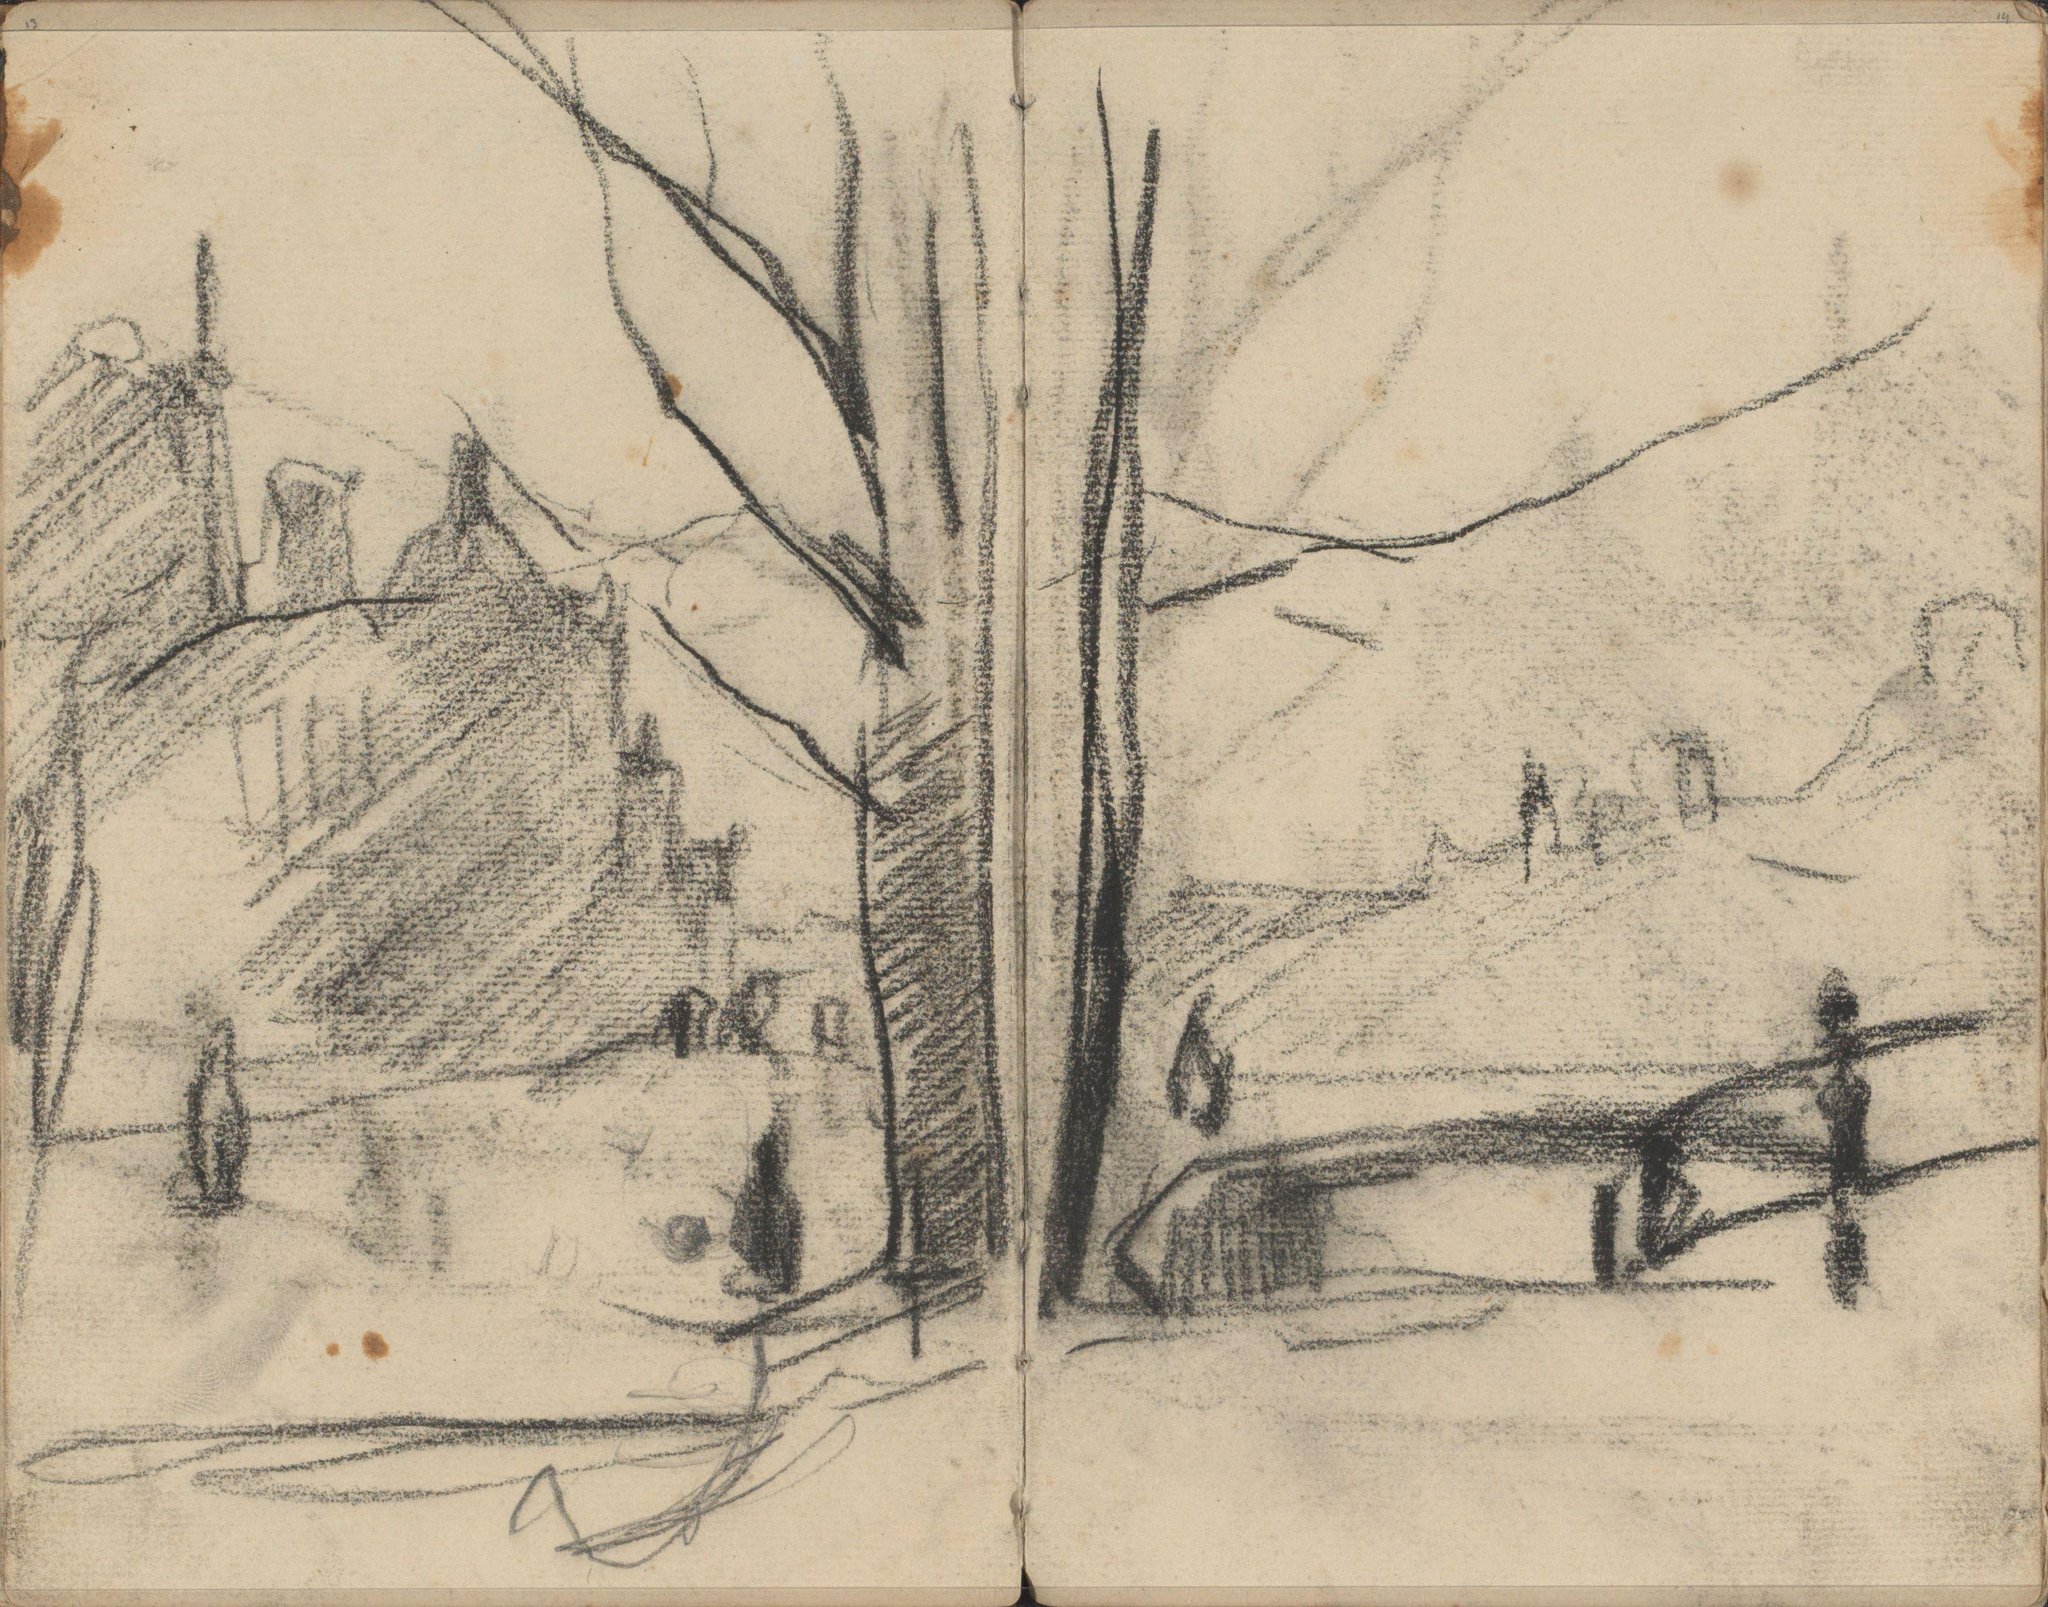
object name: sketchbook leaf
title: Gezicht op een gracht te Amsterdam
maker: george hendrik breitner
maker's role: draughtsman, painter, print maker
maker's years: 1857-1923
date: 1887-1891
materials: chalk, paper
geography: amsterdam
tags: urban housing, trees, bridge in city across river, canal, etc., amsterdam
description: In het midden een boom en rechts een brug. Pagina 13 en pagina 14 uit een schetsboek met 17 bladen.